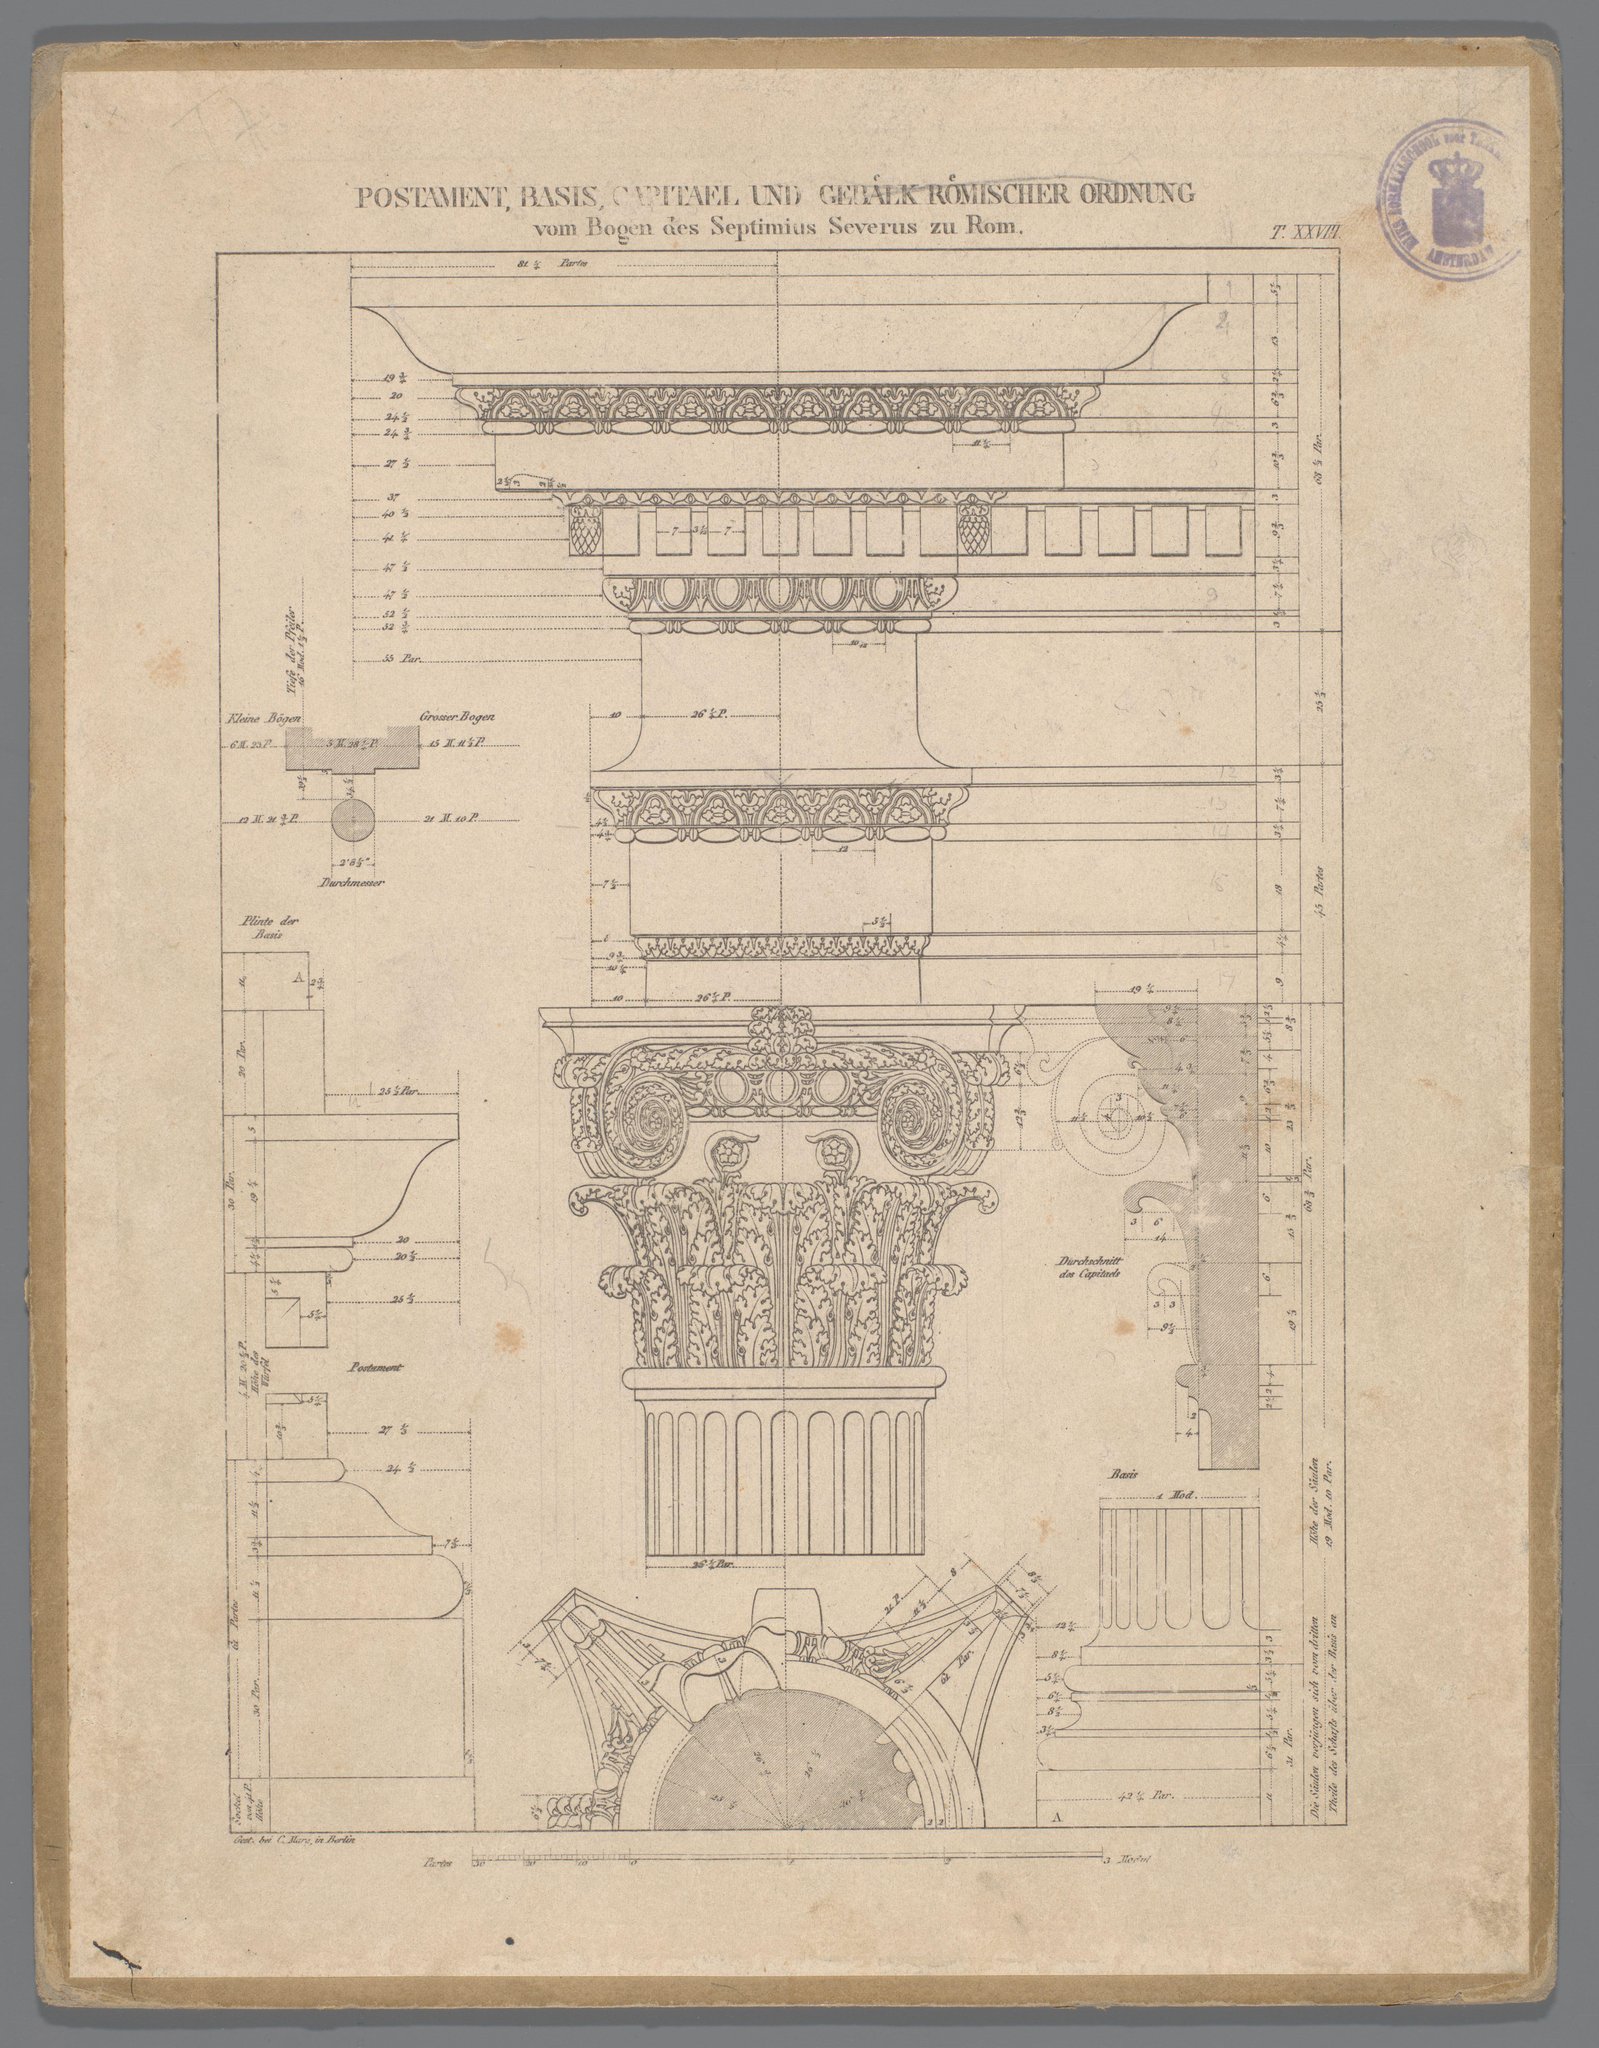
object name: photomechanical print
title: Postament, Basis, Capitael und Gebälk Römischer Ordnung/ vom Bogen des Septimius Severus zu Rom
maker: Anonymous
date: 1855-1930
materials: paper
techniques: photolithography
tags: drawing, sketch, column, pillar ~ architecture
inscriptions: annotation: ‘Komp. R.’, collector's mark: ‘RIJKS NORMAALSCHOOL voor TEE[...] AMSTERDAM’